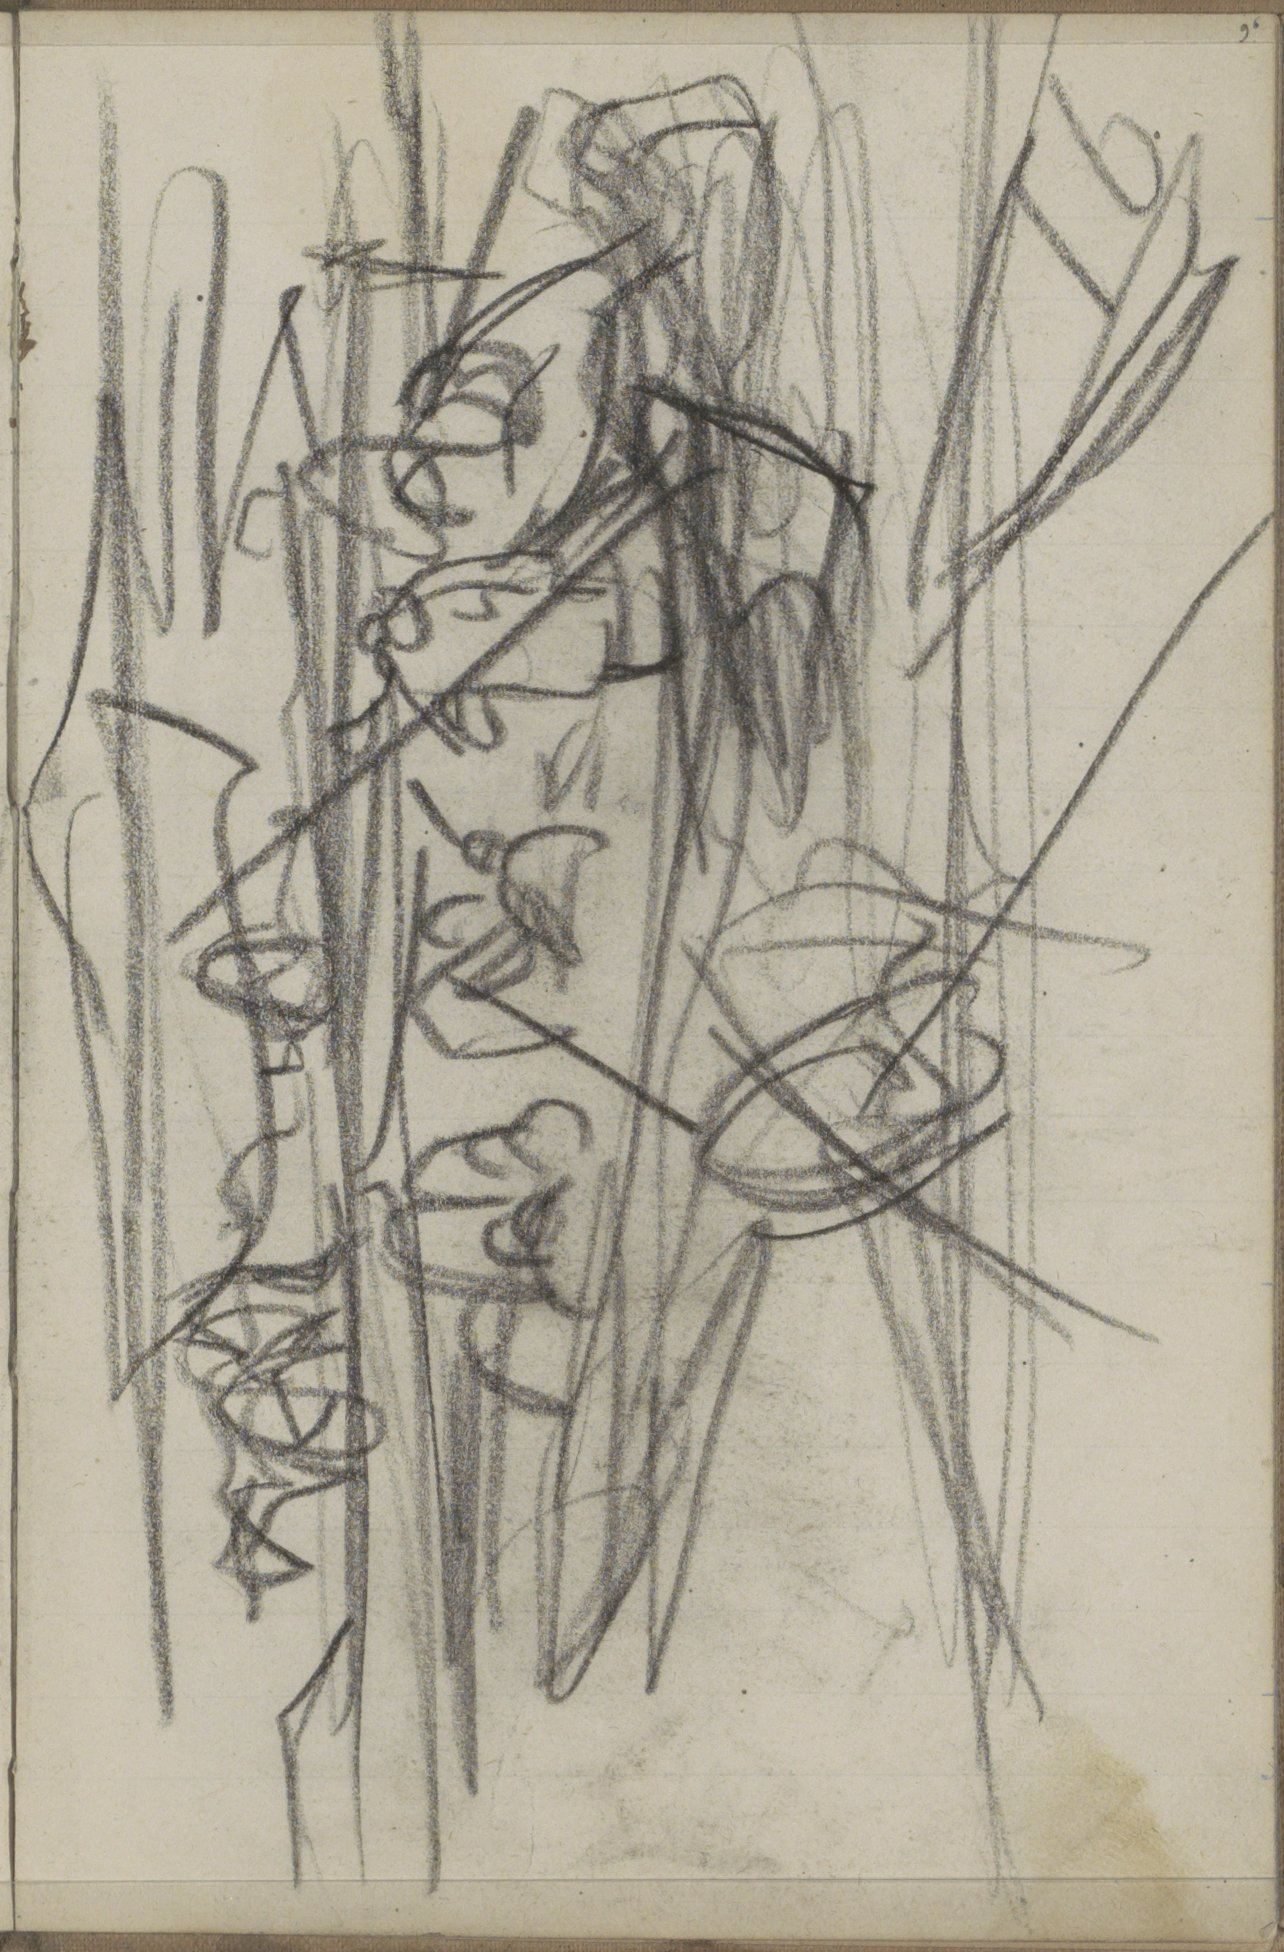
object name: sketchbook leaf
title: Studieblad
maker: marius bauer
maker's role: draughtsman, print maker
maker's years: 1867-1932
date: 1888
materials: chalk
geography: istanbul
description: Pagina 96 uit een schetsboek met 56 bladen.